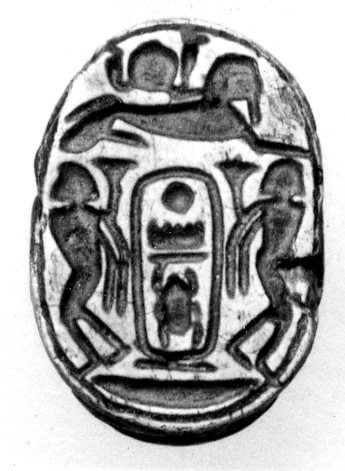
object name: scarab, thutmose iii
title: Scarab of Thutmose III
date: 1479-1425 BCE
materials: stone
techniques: glazing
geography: egypt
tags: hieroglyphs,scarabs